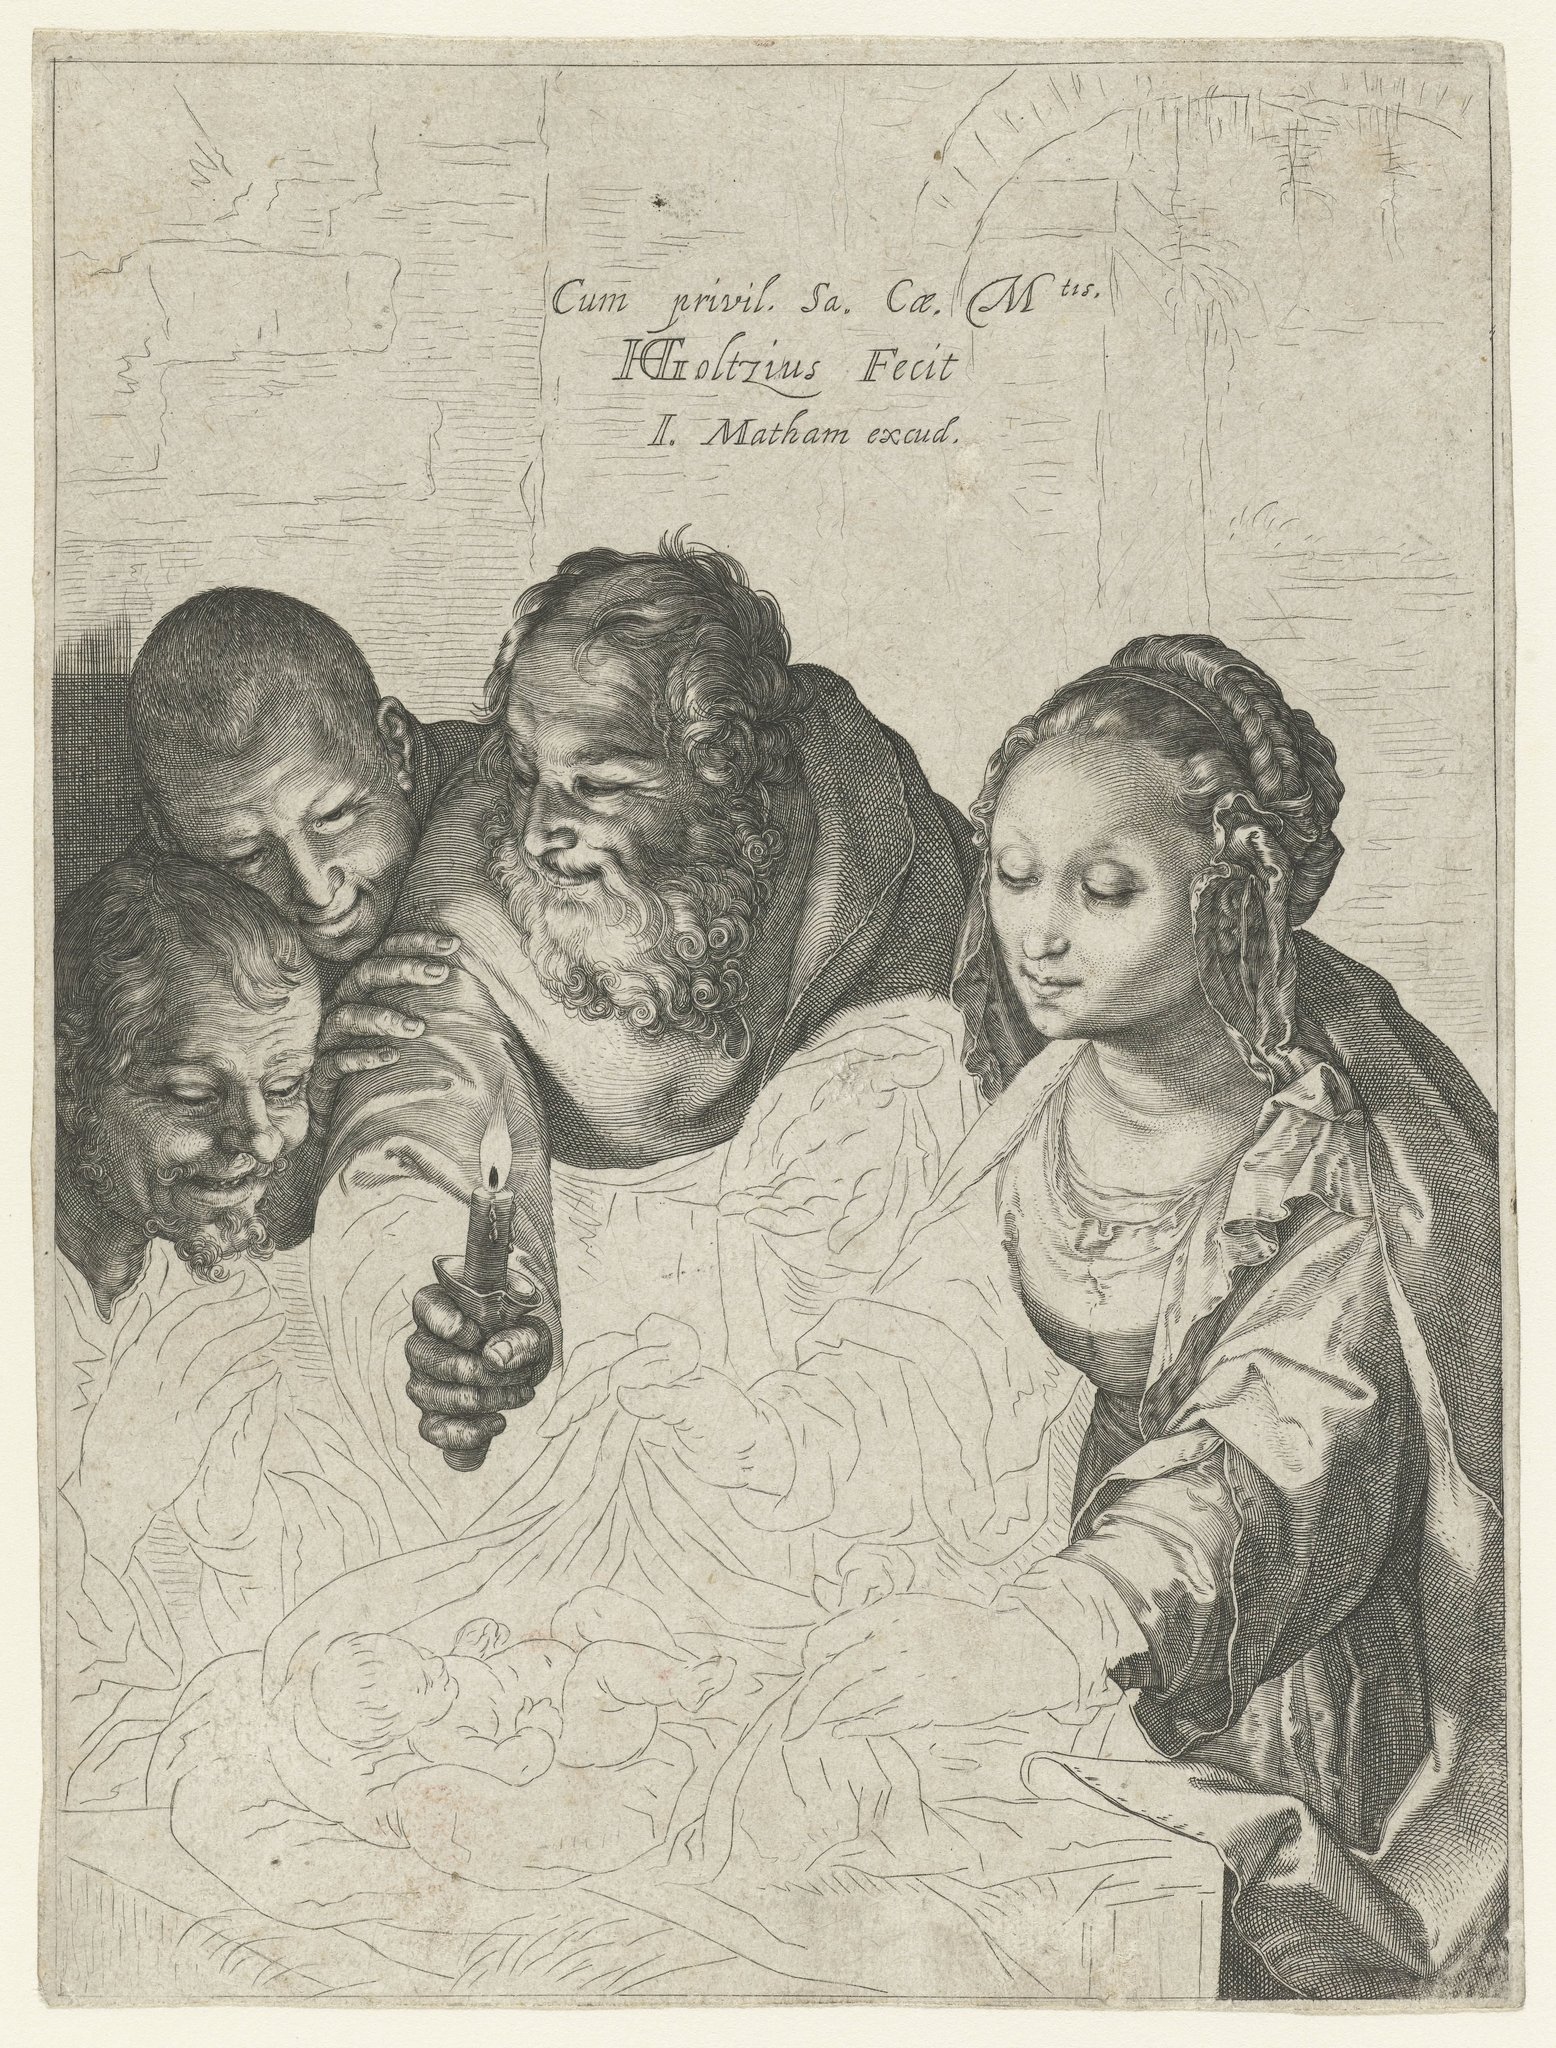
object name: print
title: Aanbidding door de herders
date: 1598-1615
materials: paper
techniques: engraving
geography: haarlem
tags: adoration of the christ-child by the shepherds; mary and joseph present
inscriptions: collector's mark: Lugt 10, signature and date: ‘Cum privil. Sa. Cae. Mtis / HGoltzius Fecit/ I. Matham excud.’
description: Onvoltooide prent van herders die het Christuskind aanbidden. Twee herders, Maria en Jozef zijn afgebeeld, de laatste met een kaars in de hand.